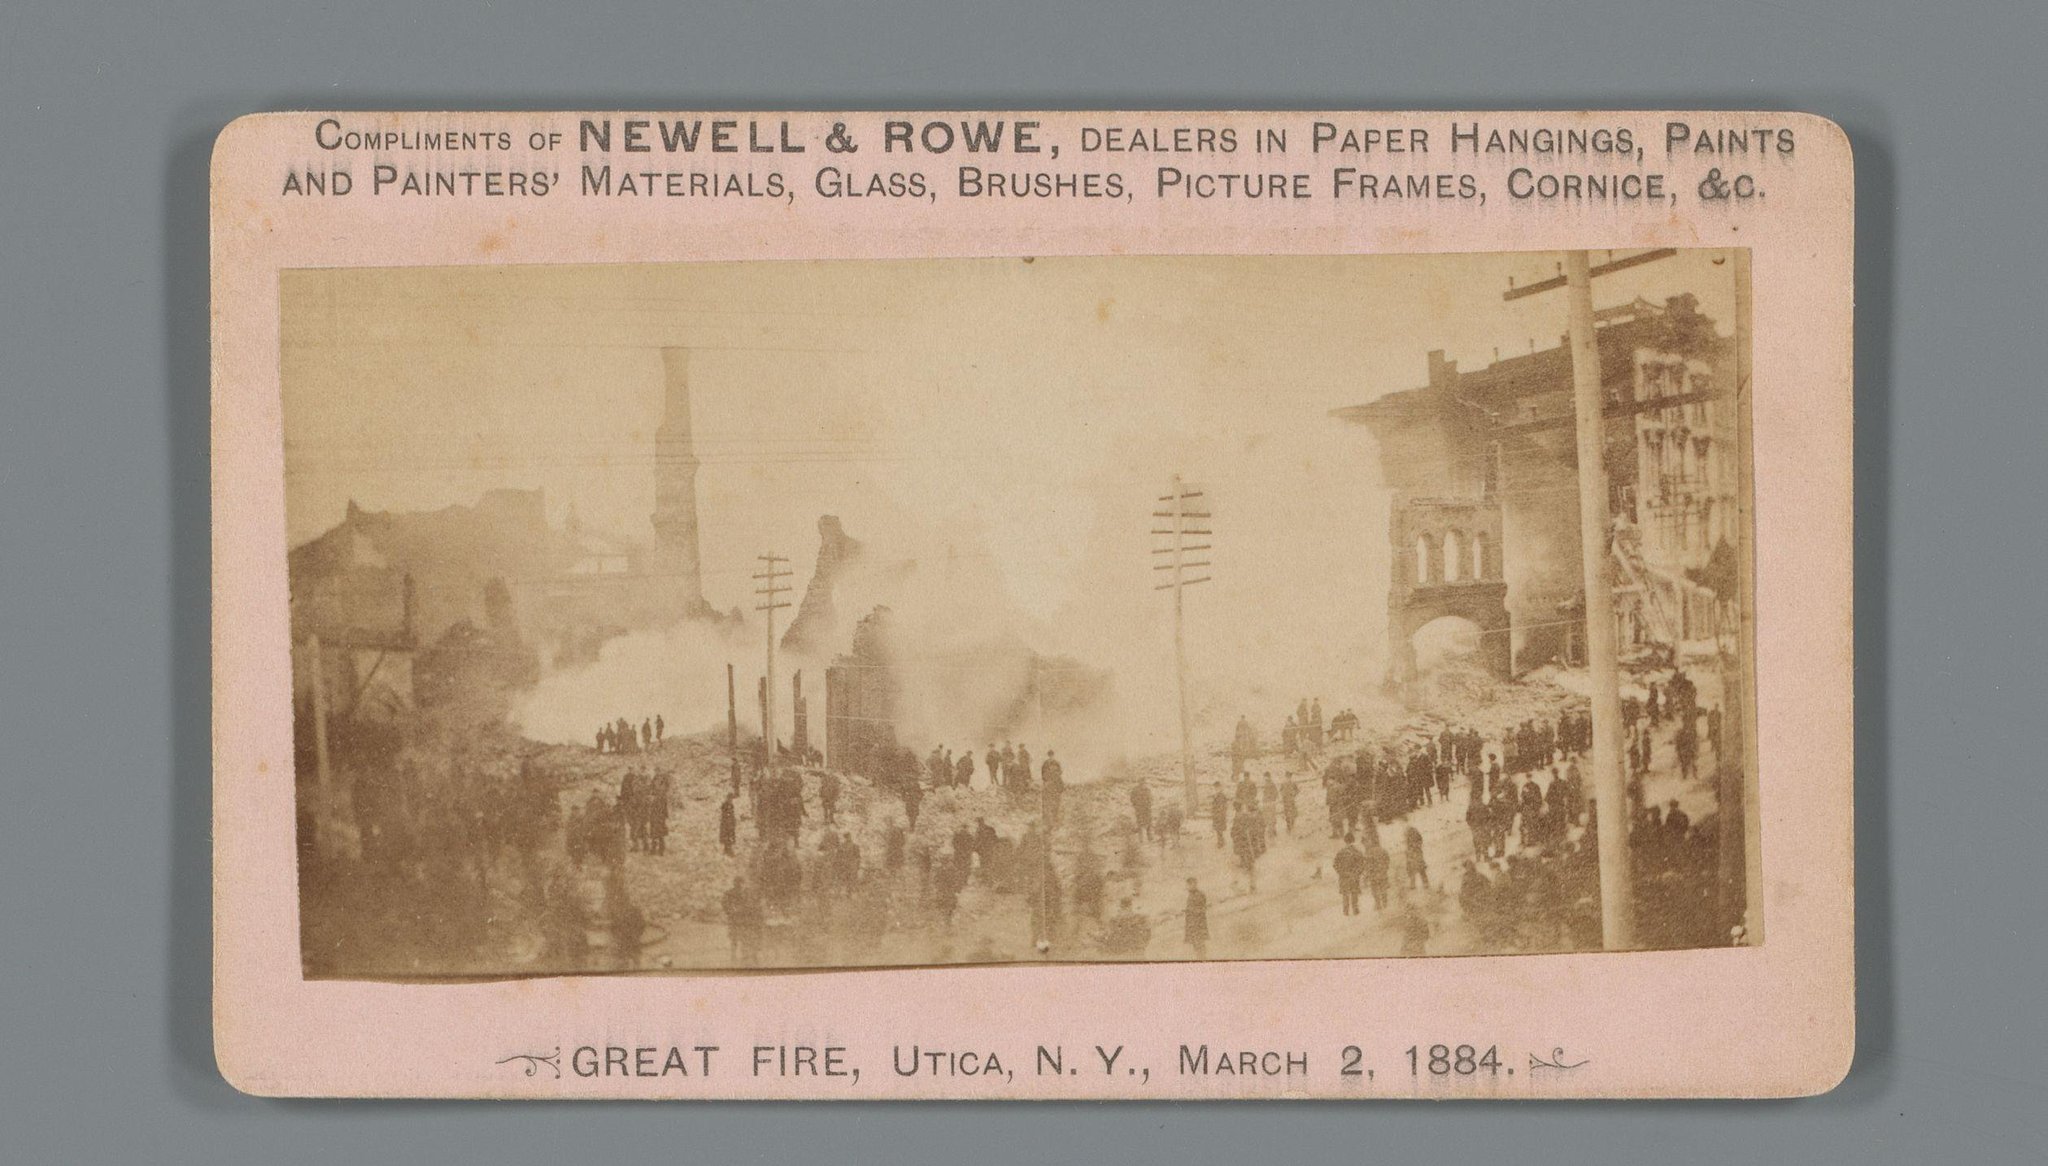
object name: photograph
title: Gezicht op de brand in Utica, New York, op 2 maart 1884 als reclame voor Newell & Rowe bouwmaterialen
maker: Anonymous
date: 1850-1915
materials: cardboard, photographic support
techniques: albumen print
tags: building materials, advertising, ruin of a building ~ architecture, open fire (in general)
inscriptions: inscription: ‘Compliment of NEWELL & ROWE, dealers in Paper Hangings, Paints/ and Painters' Materials, Glass, Brushes, Picture Frames, Cornice, &c.’, inscription: ‘This business was Established/ by Jesse Newell in 1812; the firm/ was then changed to Jesse Newell/ and Son; afterward carried on by/ N.C. Newell; then N.C. Newell &/ Son, - N.C. Newell having been in/ the same store 111 Genesee St./ for sicty years, now retires and/ NEWELL & ROWE will continue./ Utica, March, 1884. {CHARLES N. NEWELL/ JAMES W. ROWE.’